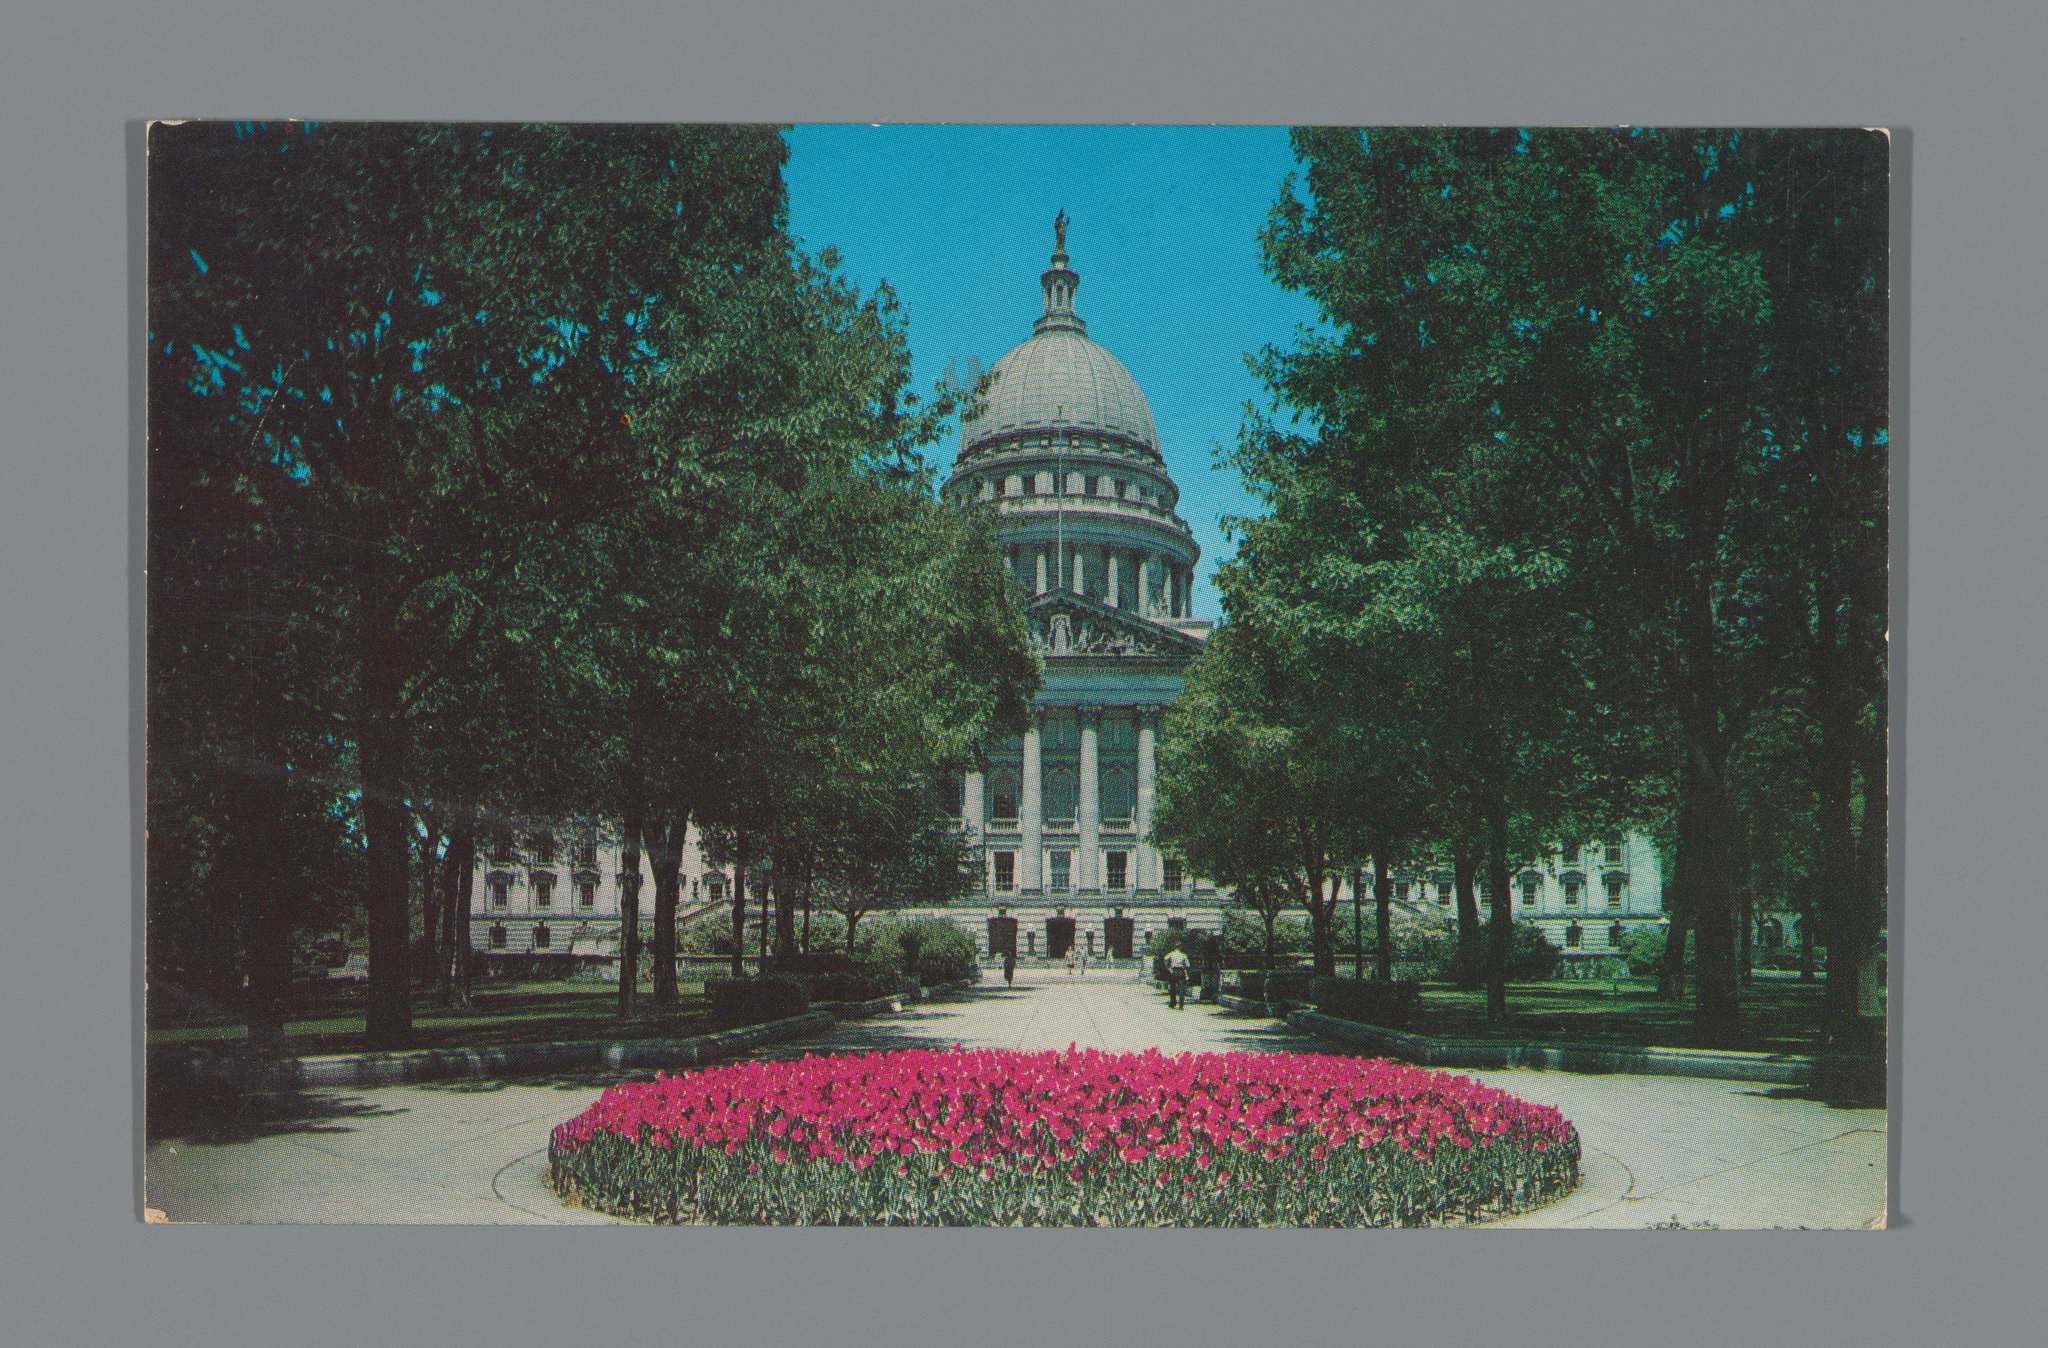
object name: ansichtkaart, prentbriefkaart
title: State Capitol, Madison, Wisconsin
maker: Anonymous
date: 1954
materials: paper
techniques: four-color autotype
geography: madison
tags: madison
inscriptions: inscription: ‘STATE CAPITOL – MADISON, WISCONSIN […] / Copyright 1954, The L. L. Cook Co. / 48206 / From A Natural Color Transparency. The L. L. Cook Co., Milwaukee, Wis.’